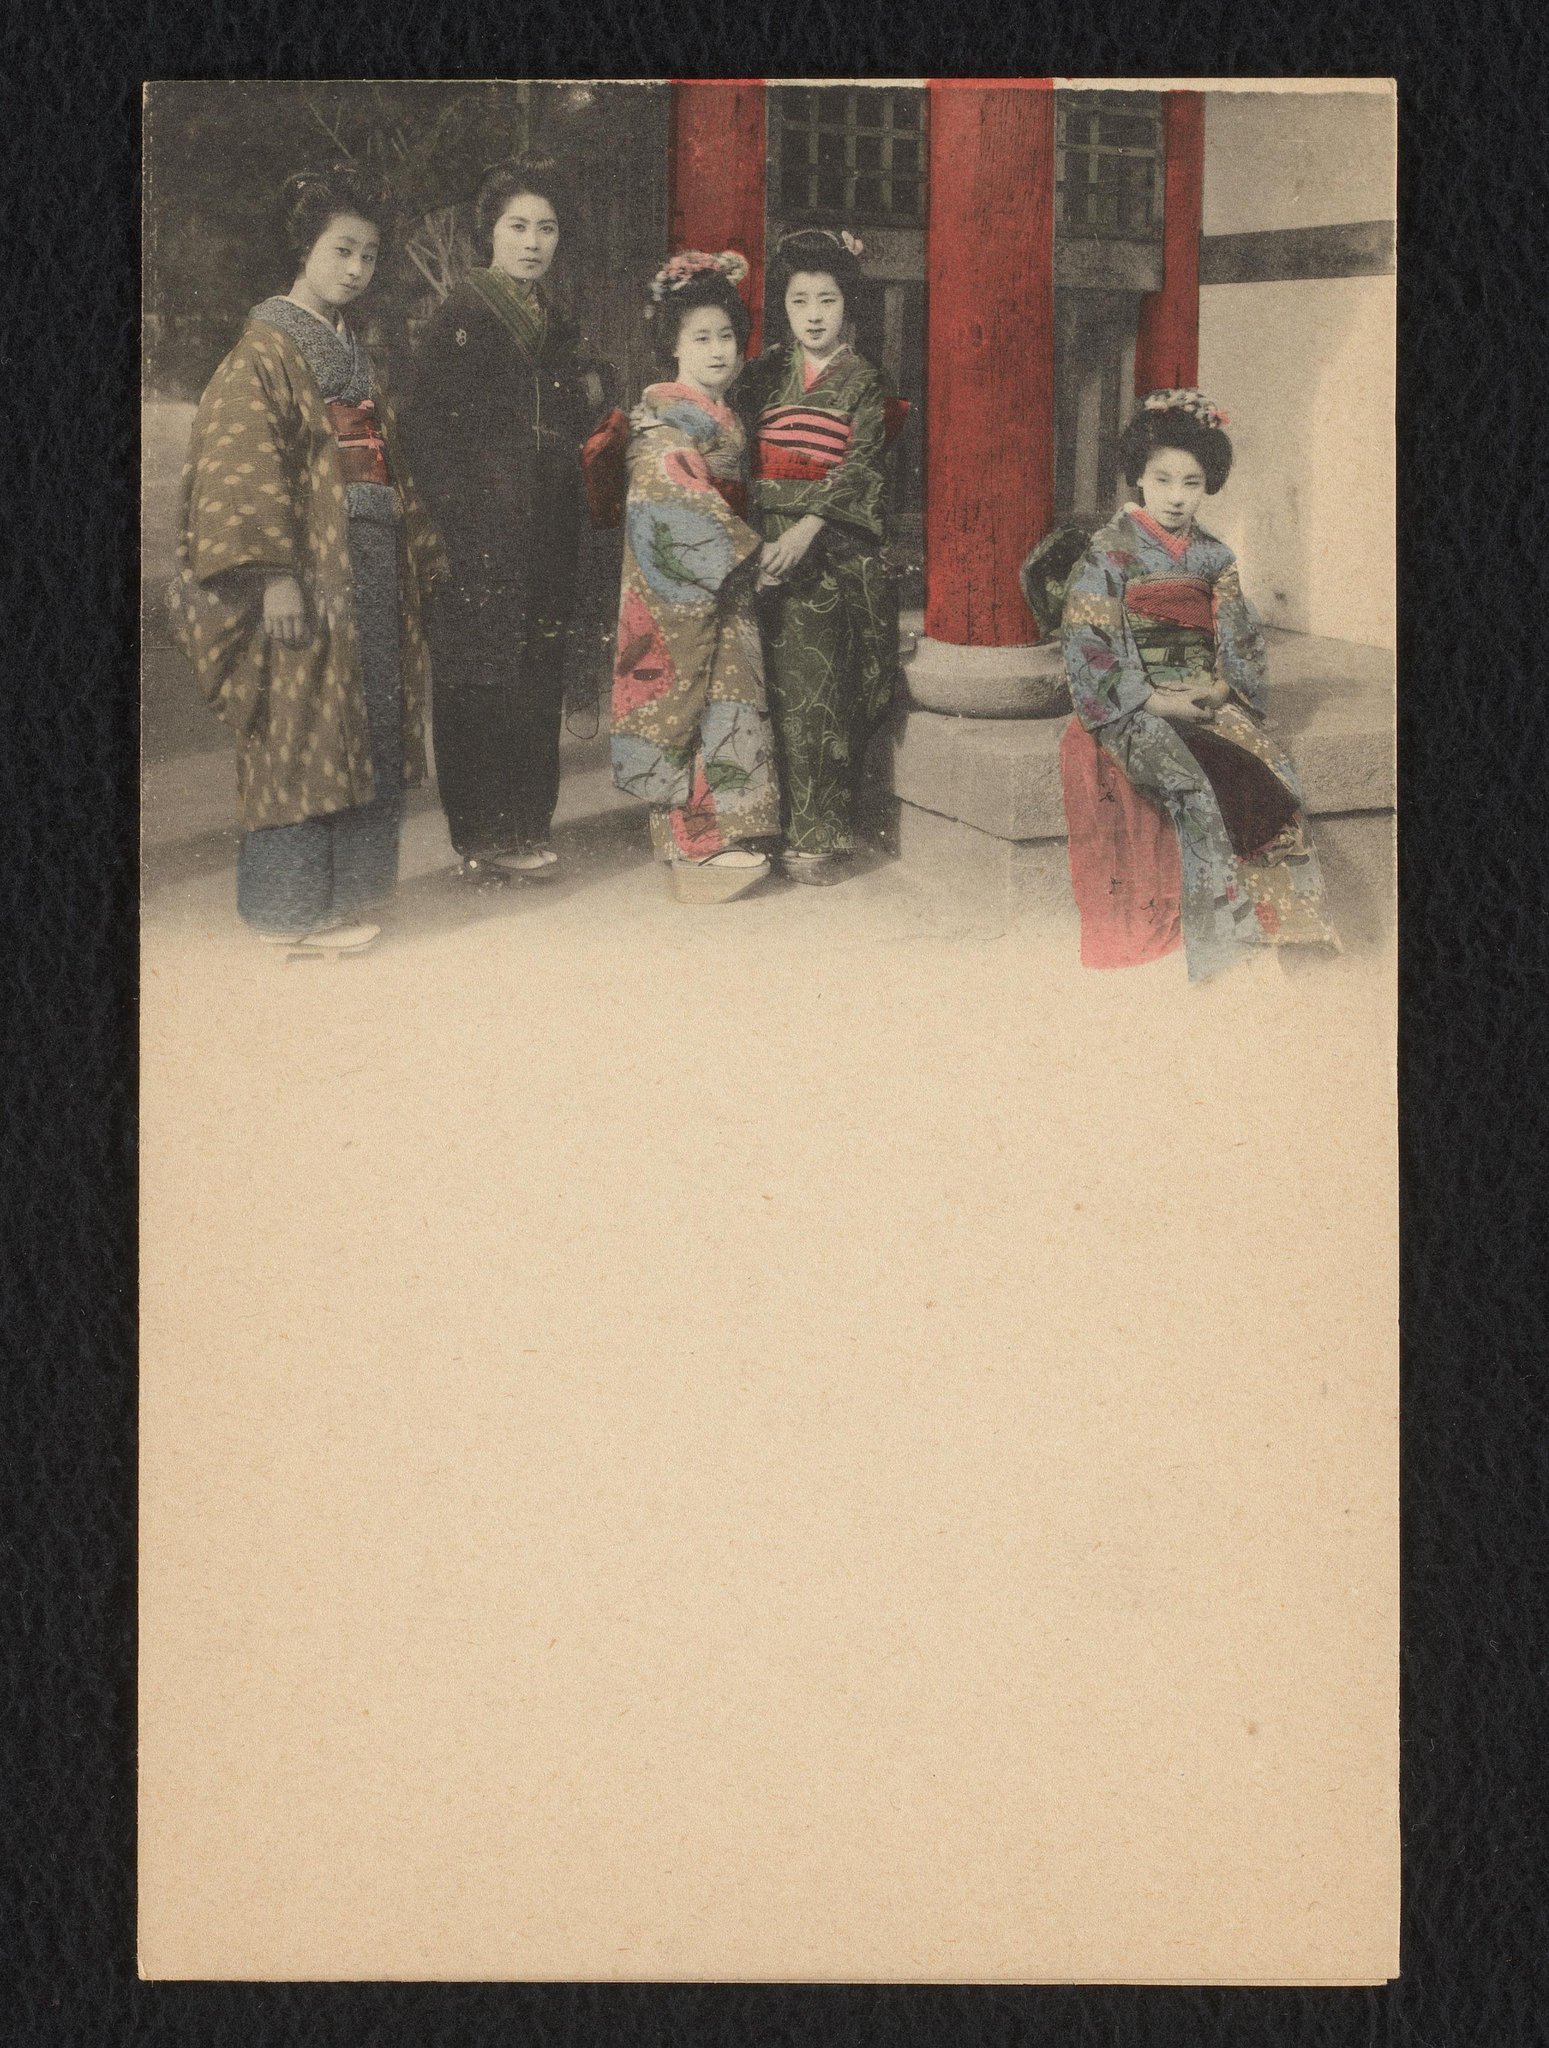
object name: stationery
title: Groepsportret van vijf onbekende jonge Japanse vrouwen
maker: Anonymous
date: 1890-1920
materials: paper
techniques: photograph, lithograph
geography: japan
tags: anonymous historical persons portrayed in a group, in a group-portrait - bb - woman, japan